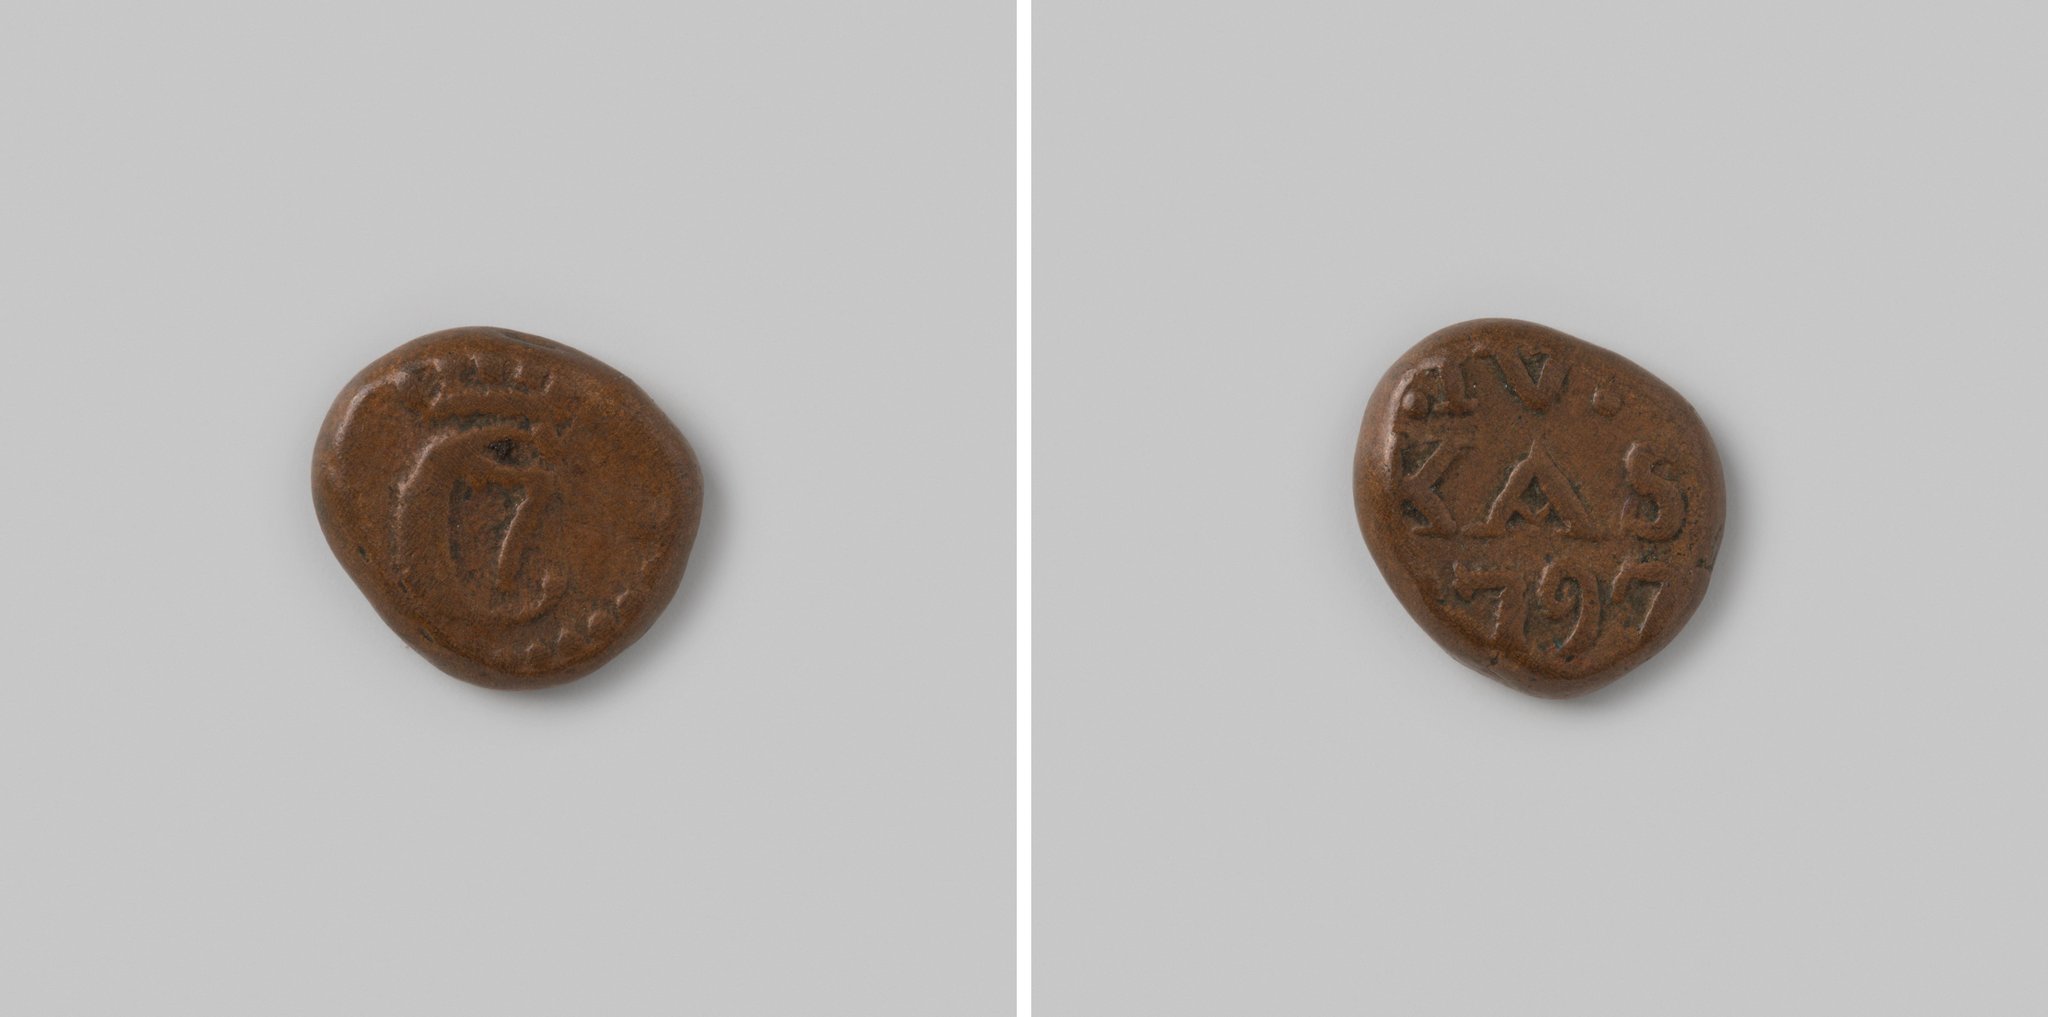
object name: coin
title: Tranquebar, Deens-India, Deense Aziatische Compagnie (DAC) op naam van koning Christiaan VII, 4 kas, 1797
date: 1797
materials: copper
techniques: striking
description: Koperen munt. Voorzijde: gekroond monogram van de koning. Keerzijde: in twee regels waarde-aanduiding: IV. kas. Daaronder jaartal.